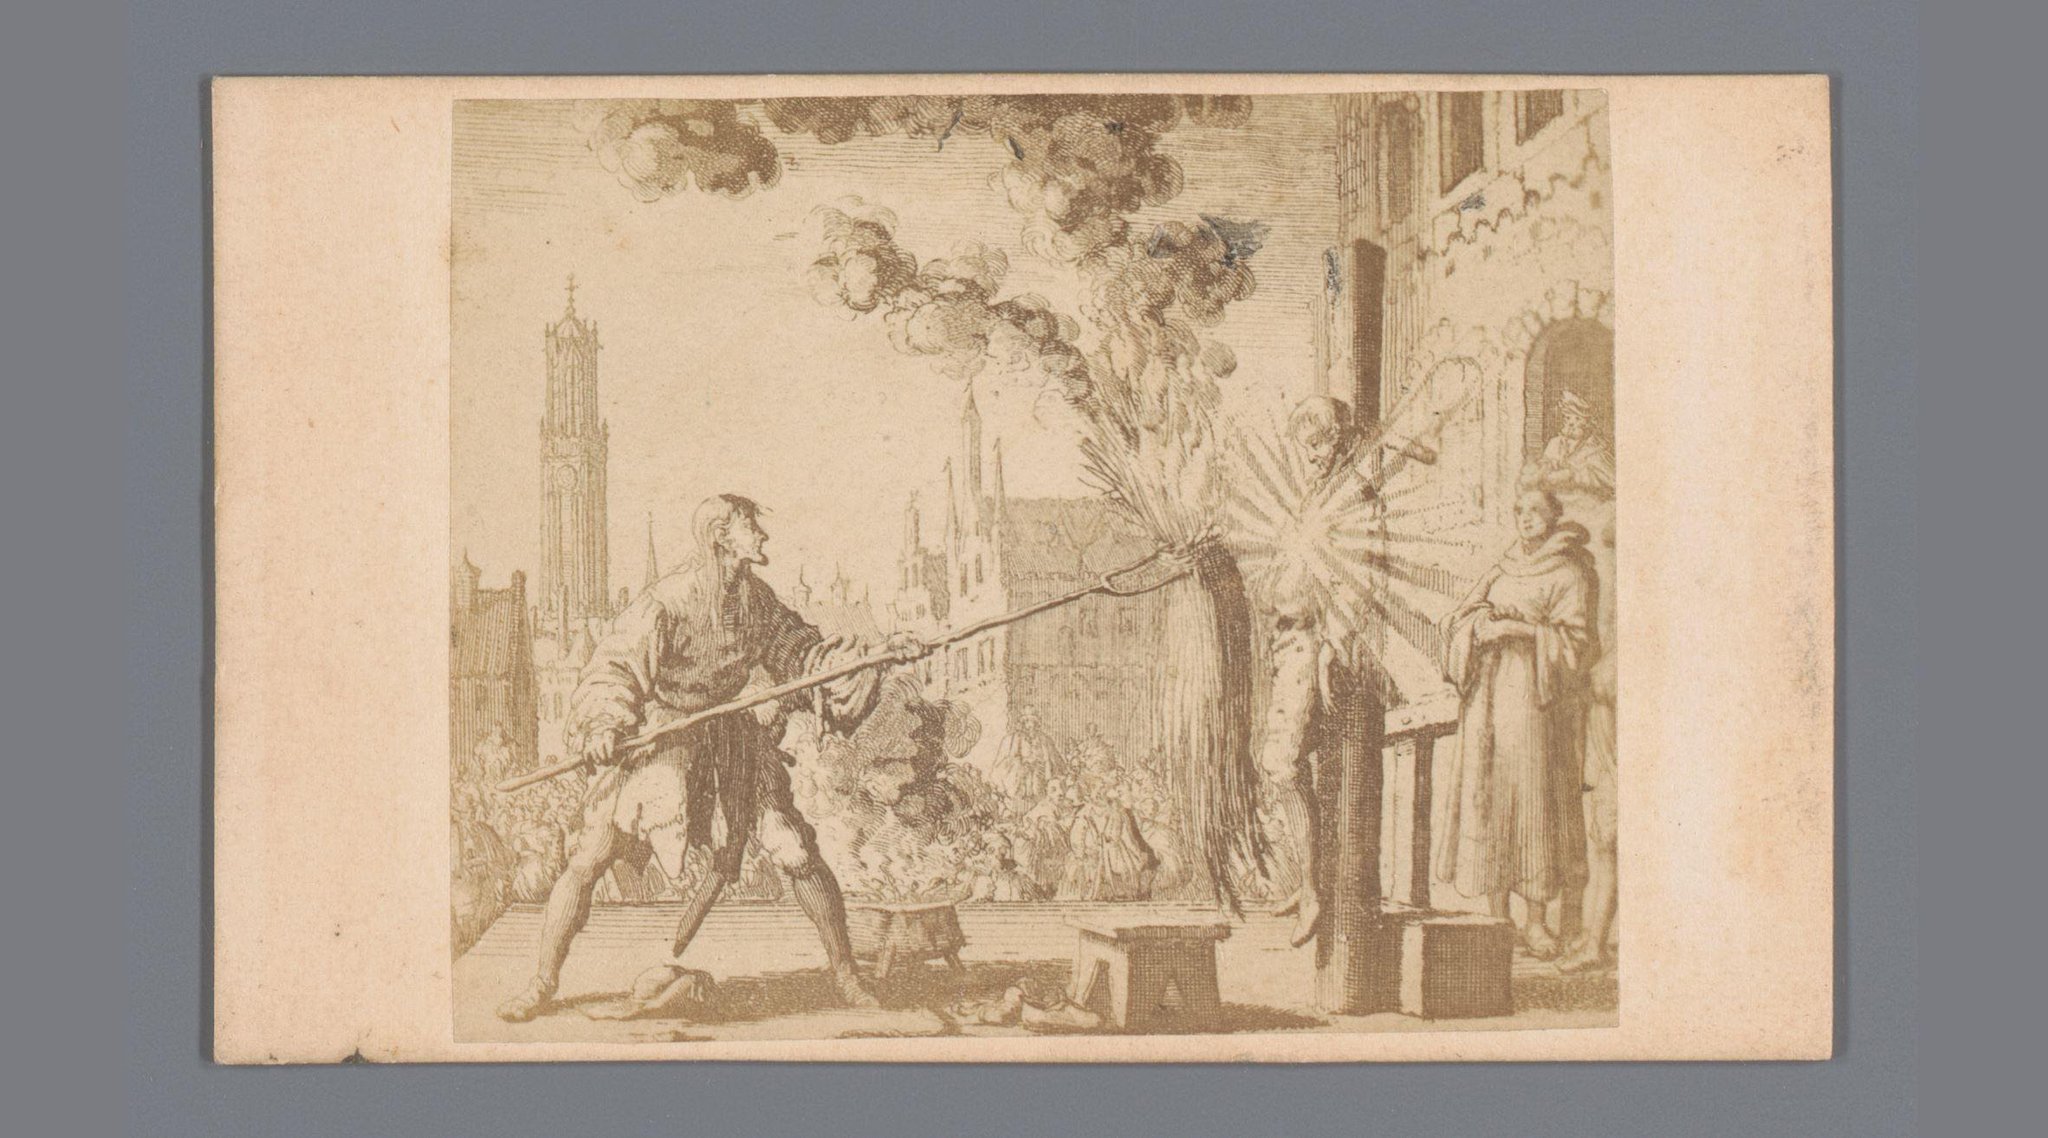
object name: carte de visite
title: Fotoreproductie van een prent van De executie van Hendrik Eemkens, door Jan Luyken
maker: Anonymous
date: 1855-1885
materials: cardboard, paper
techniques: albumen print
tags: projectiles, explosives, etc.: gunpowder, execution of heretic, e.g. by burning at the stake, 'auto-da-fé', violent death by having part of the body tortured with fire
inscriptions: inscription: ‘Dit plaatje stelt weêr eene andere wijze (...) de borst gehangen was, in brand.’, number: ‘No. 5.’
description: De oorspronkelijke prent van Jan Luyken is van 1683-1685. Zie ook RP-P-OB-78.438.